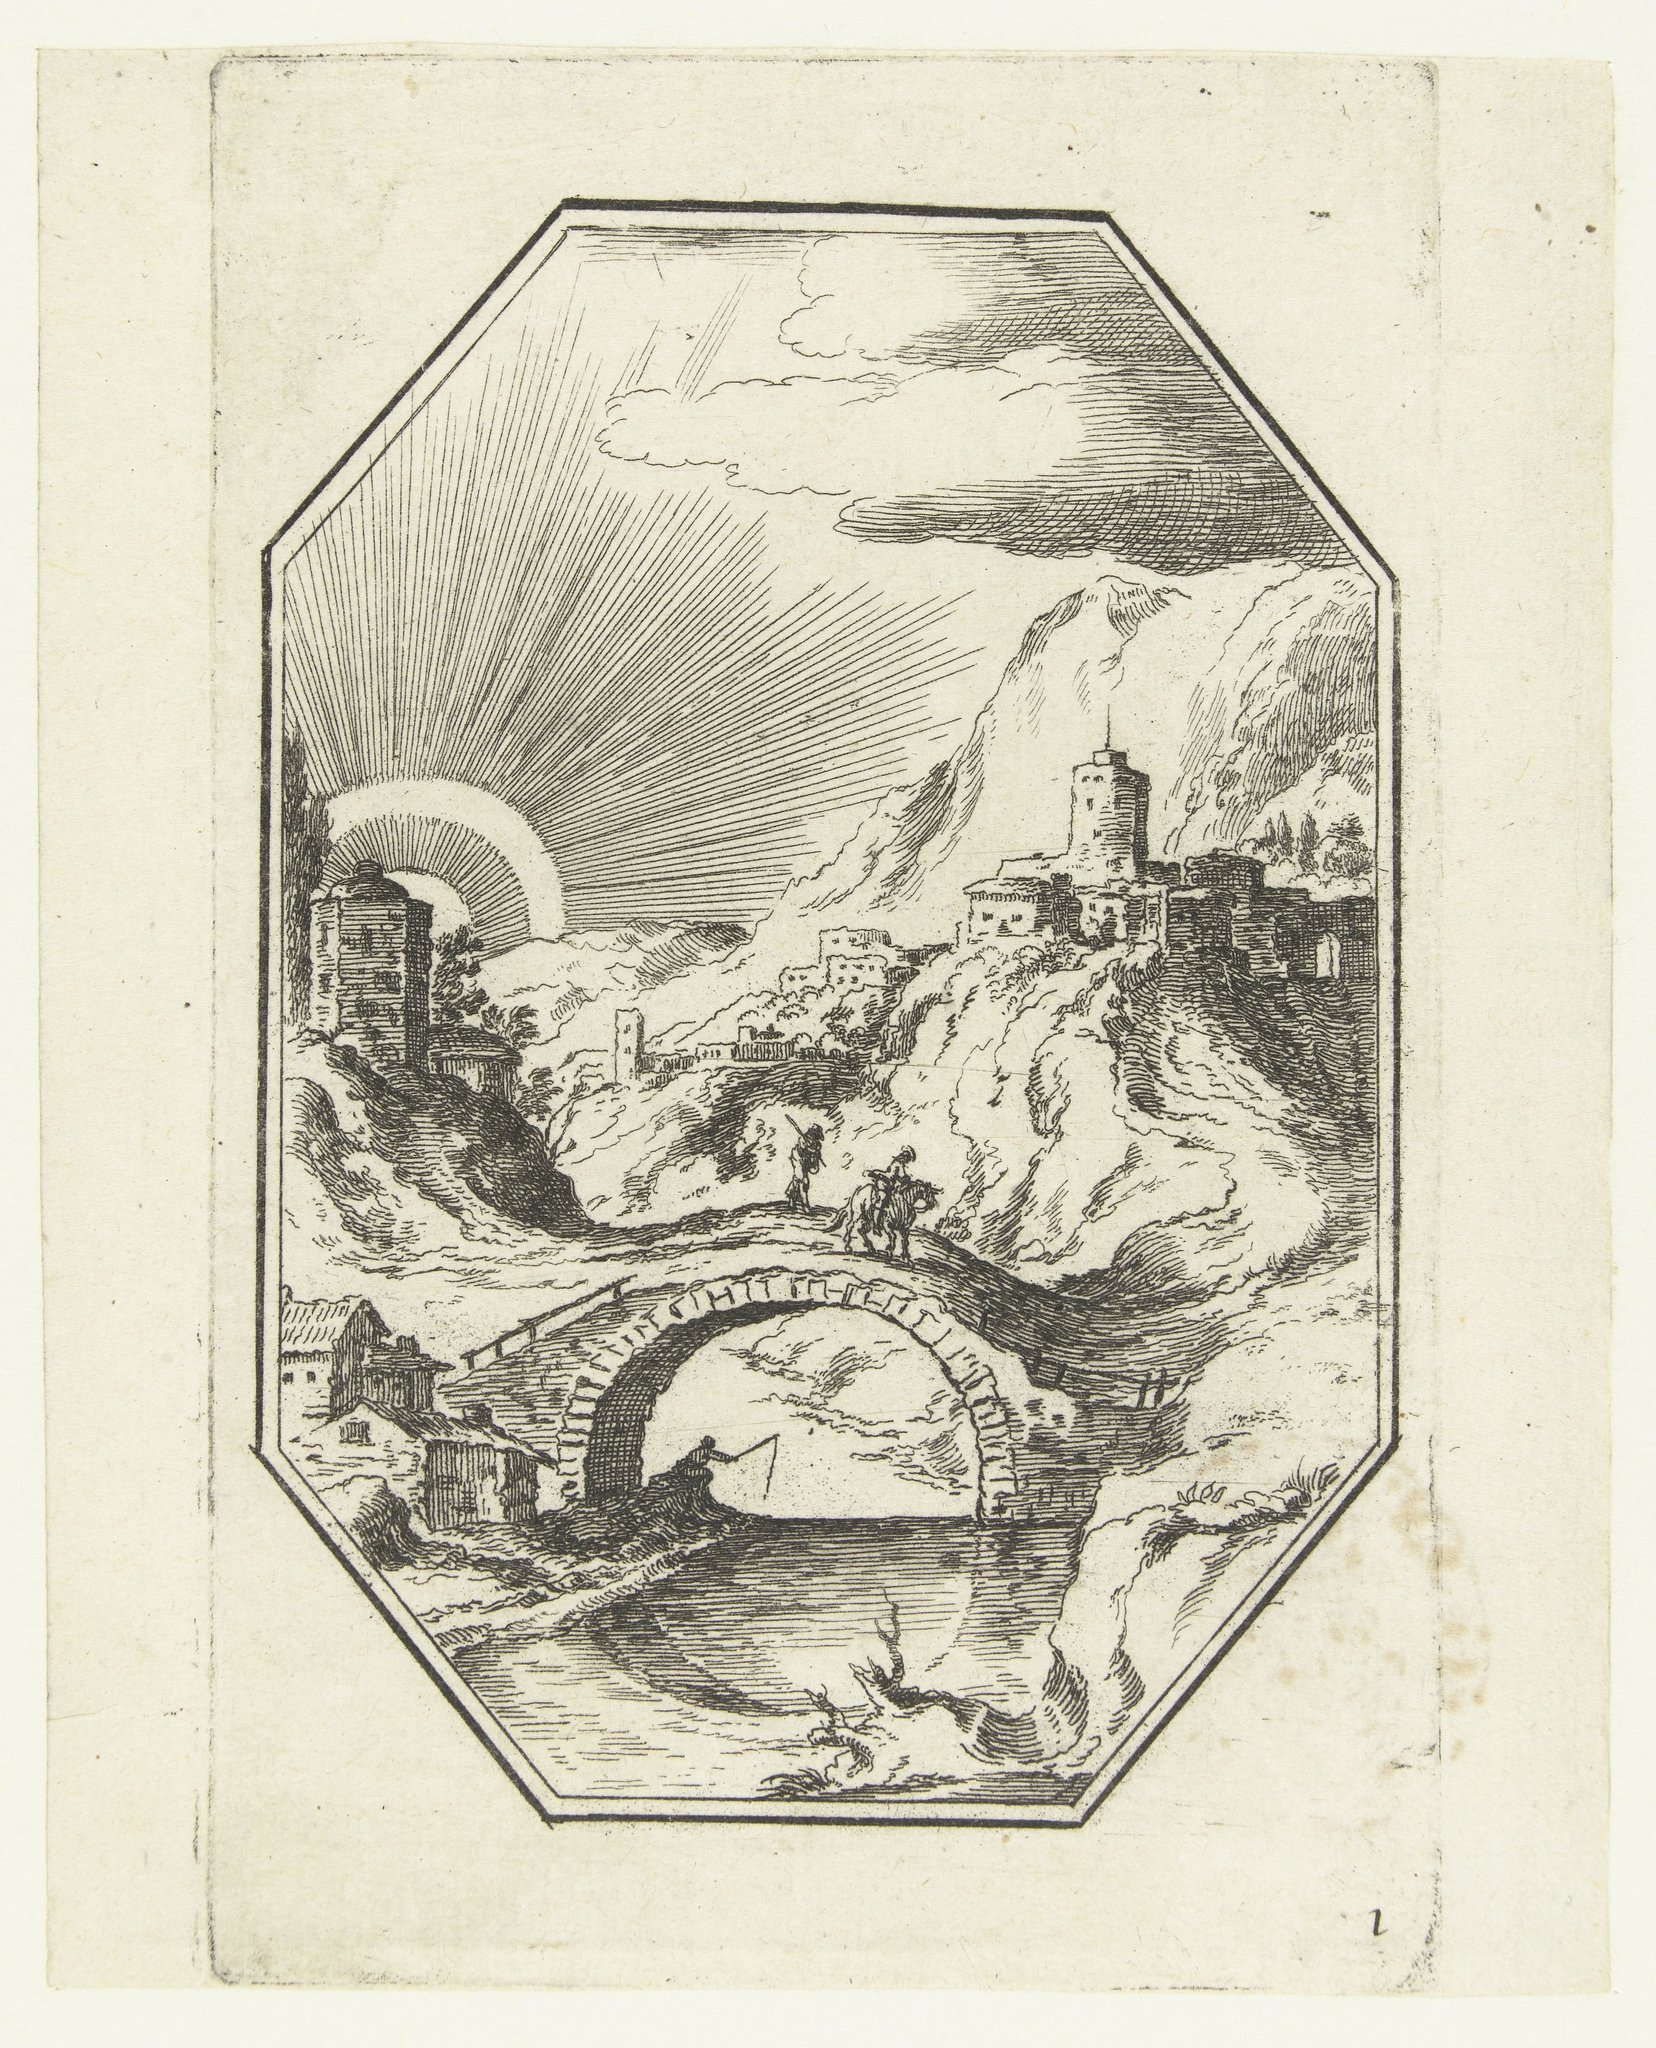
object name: print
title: Landschap met stenen brug in octagonaal kader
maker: Anonymous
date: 1582-1700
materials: paper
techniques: etching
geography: italy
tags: landscape with bridge, viaduct or aqueduct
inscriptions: collector's mark: Lugt 240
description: Landschap met stenen brug in octagonaal kader, kopie naar prent van Paul Bril met voorstelling spiegelverkeerd weergegeven.